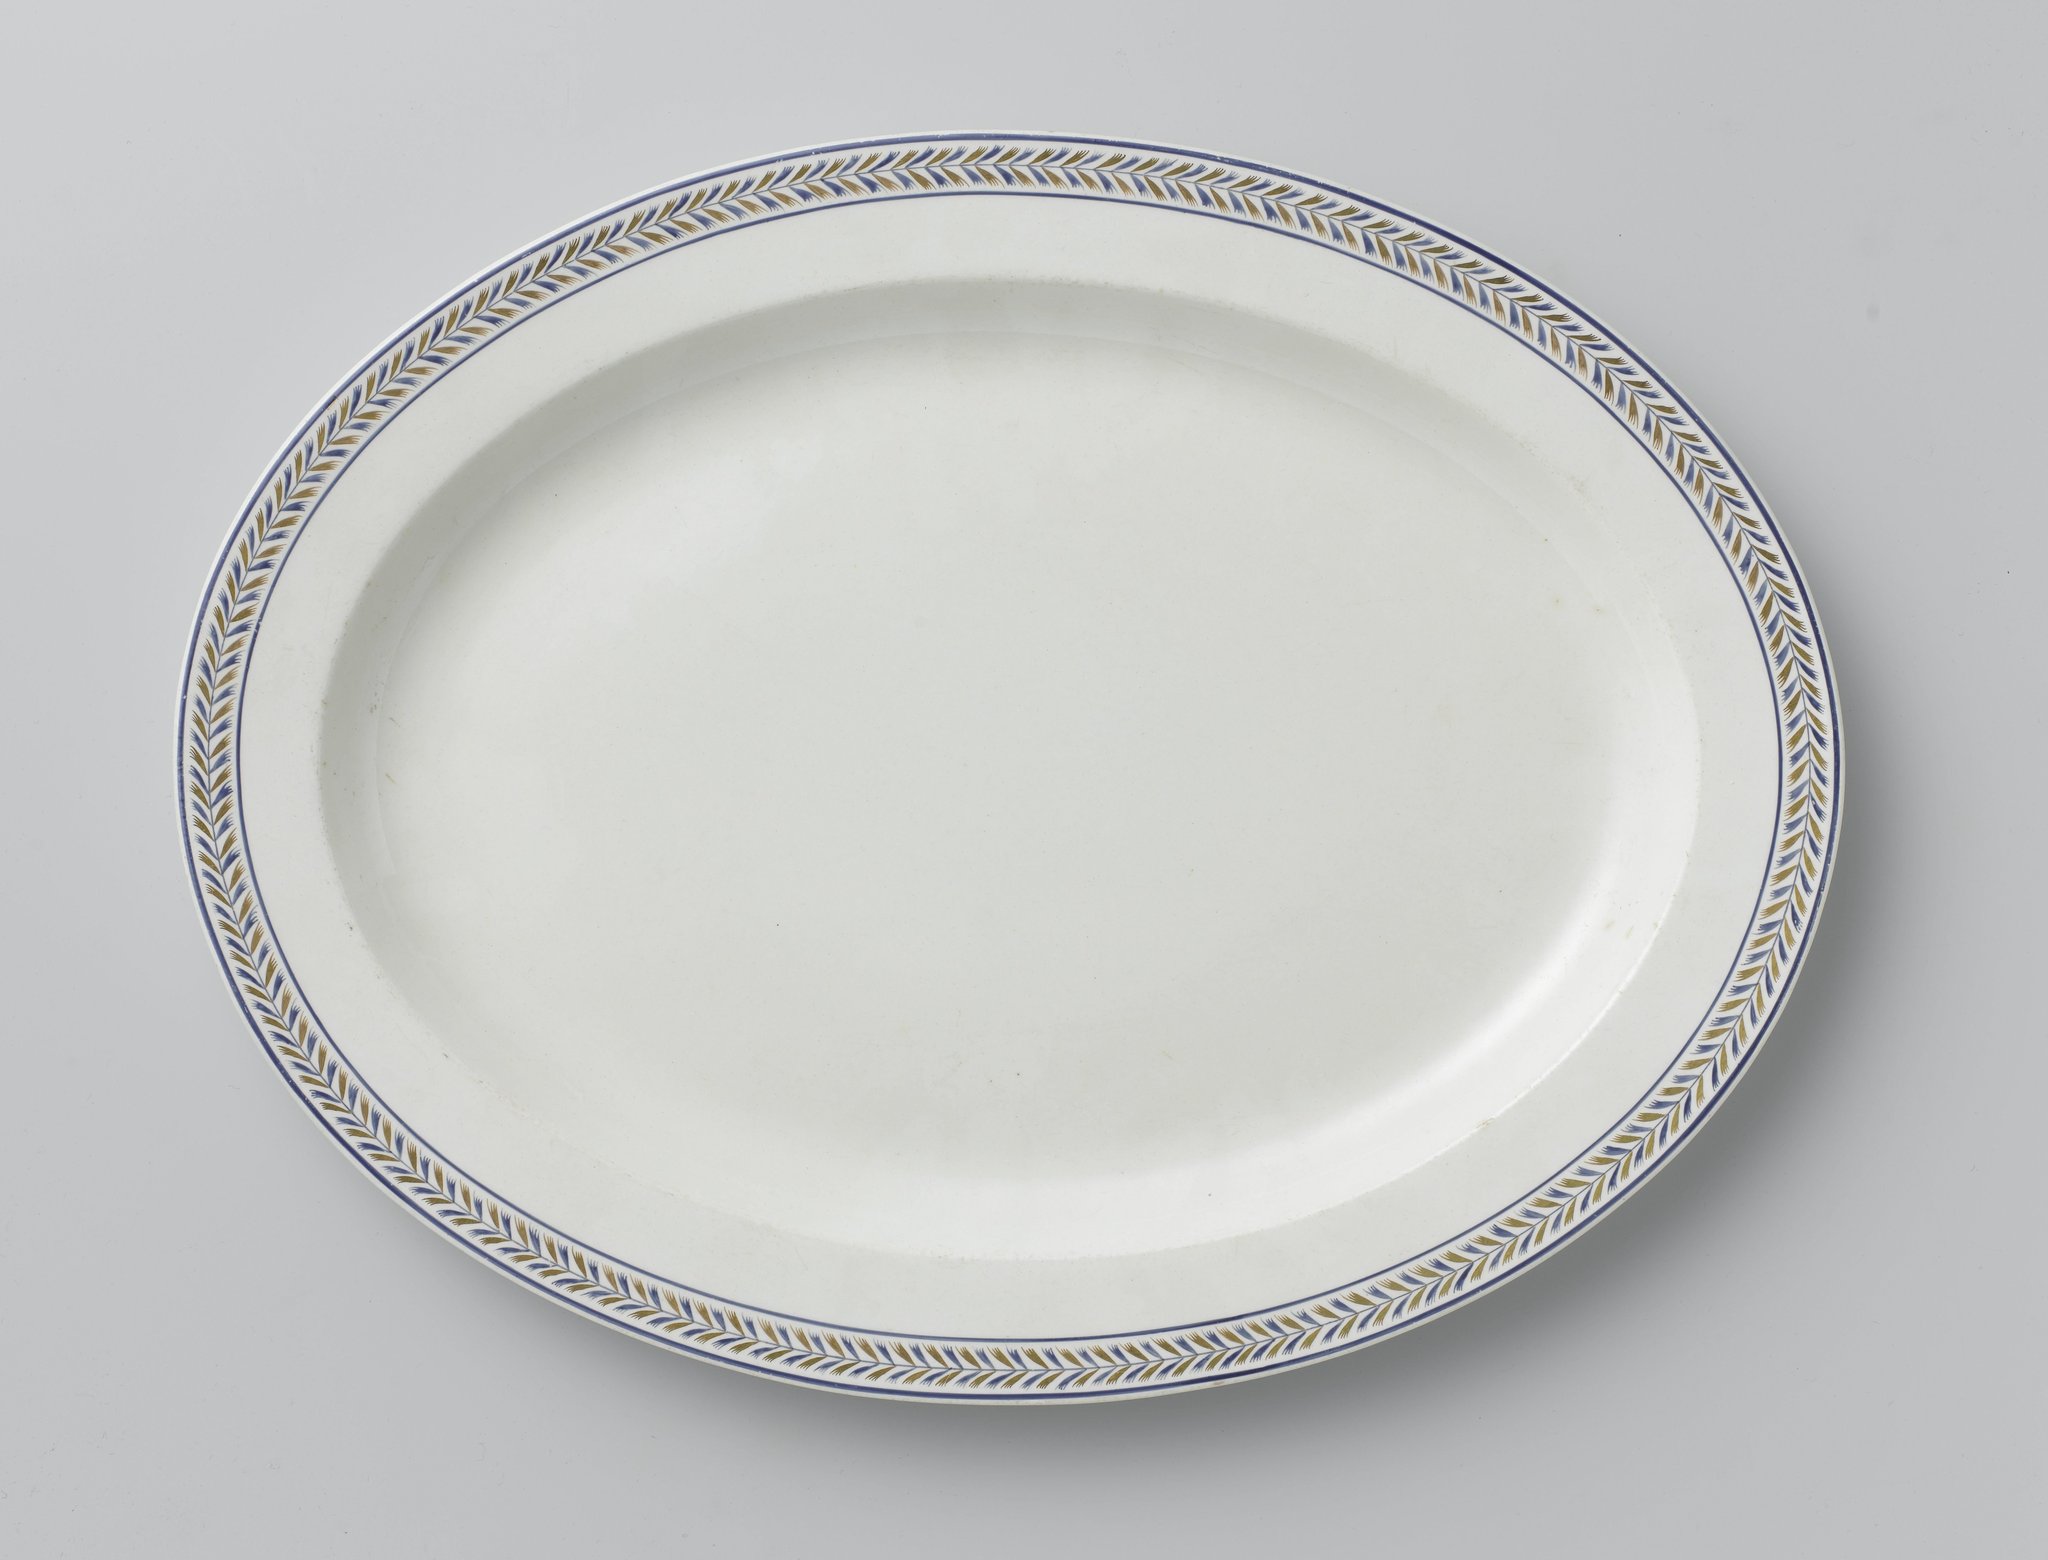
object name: platter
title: Schotel van hardgebakken aardewerk, Wedgwood cream ware.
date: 1800-1815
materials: earthenware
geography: england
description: Schotel van hardgebakken aardewerk. De rand is versierd met ornamentbanden, bestaande uit een doorlopende blauwe tak met afwisselend blauwe en gouden bladeren tussen blauwe biezen. De schotel is gemerkt. De schotel hoort bij een terrine (BK-1960-30-A) en een broodschaal (BK-1960-30-B).